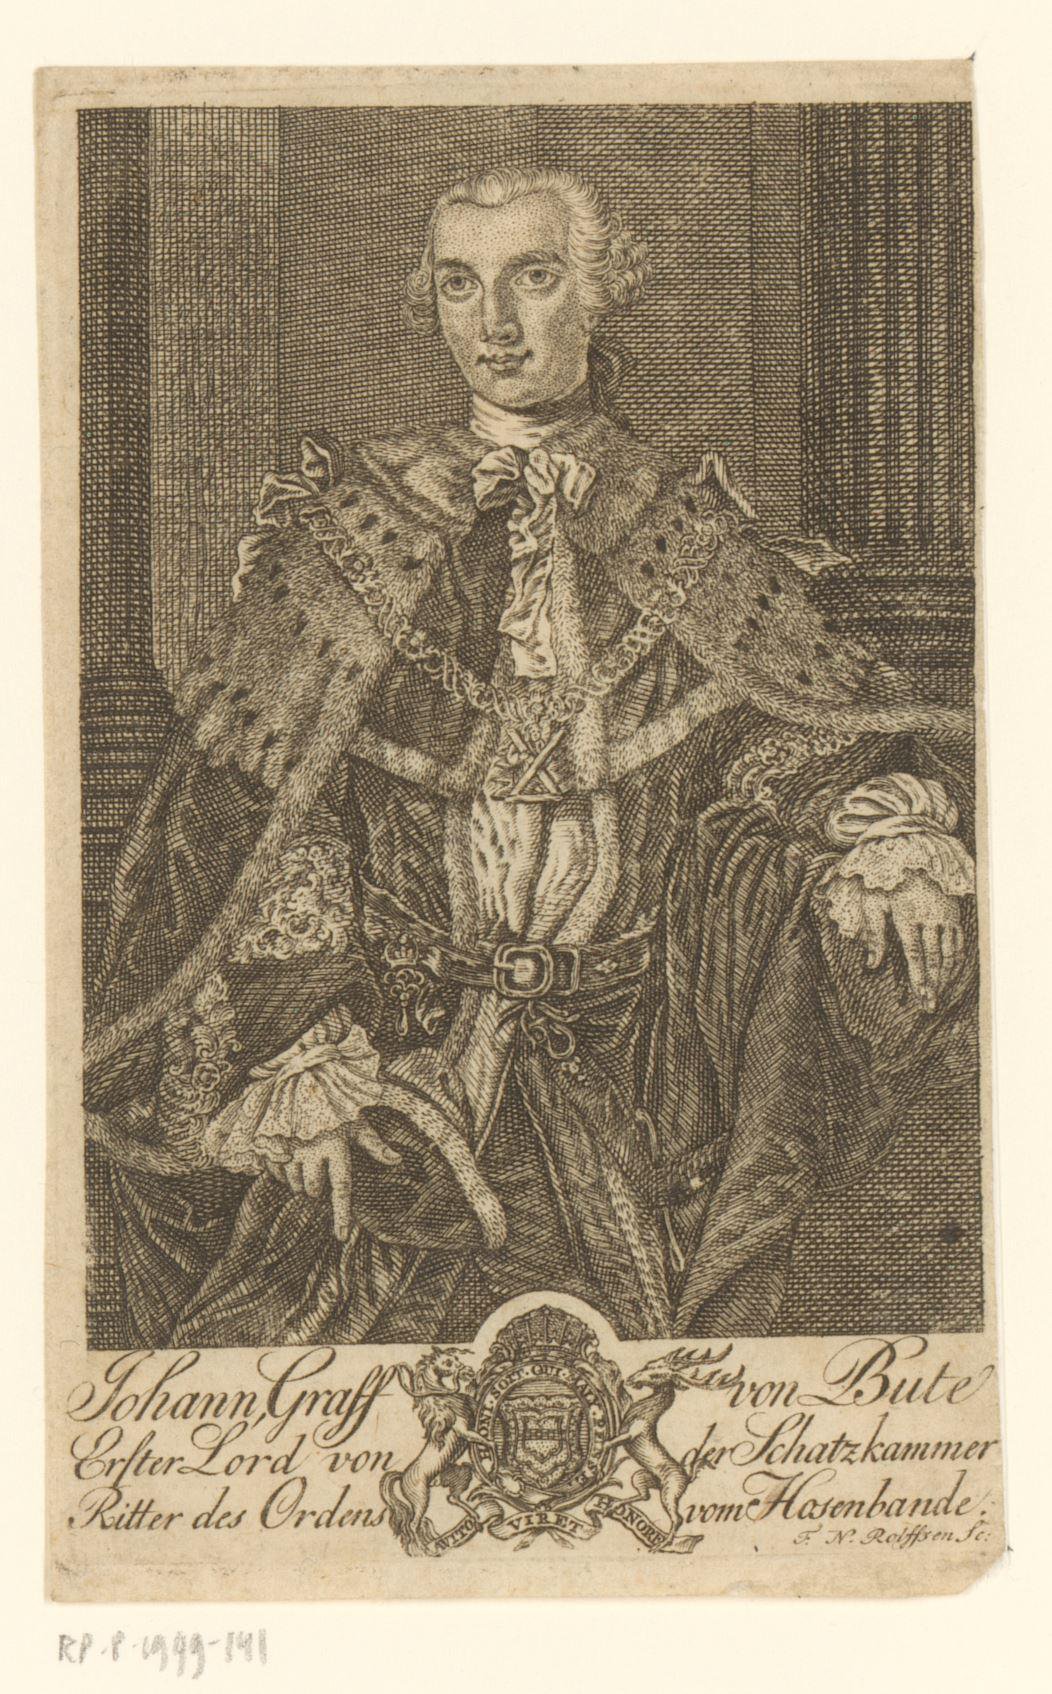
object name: print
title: Portret van John Stuart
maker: franz nikolaus rolffsen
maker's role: print maker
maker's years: 1719-1802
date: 1729-1802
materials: paper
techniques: engraving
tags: john stuart, historical persons, armorial bearing, heraldry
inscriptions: collector's mark: Lugt 2760, collector's mark: Lugt 2228